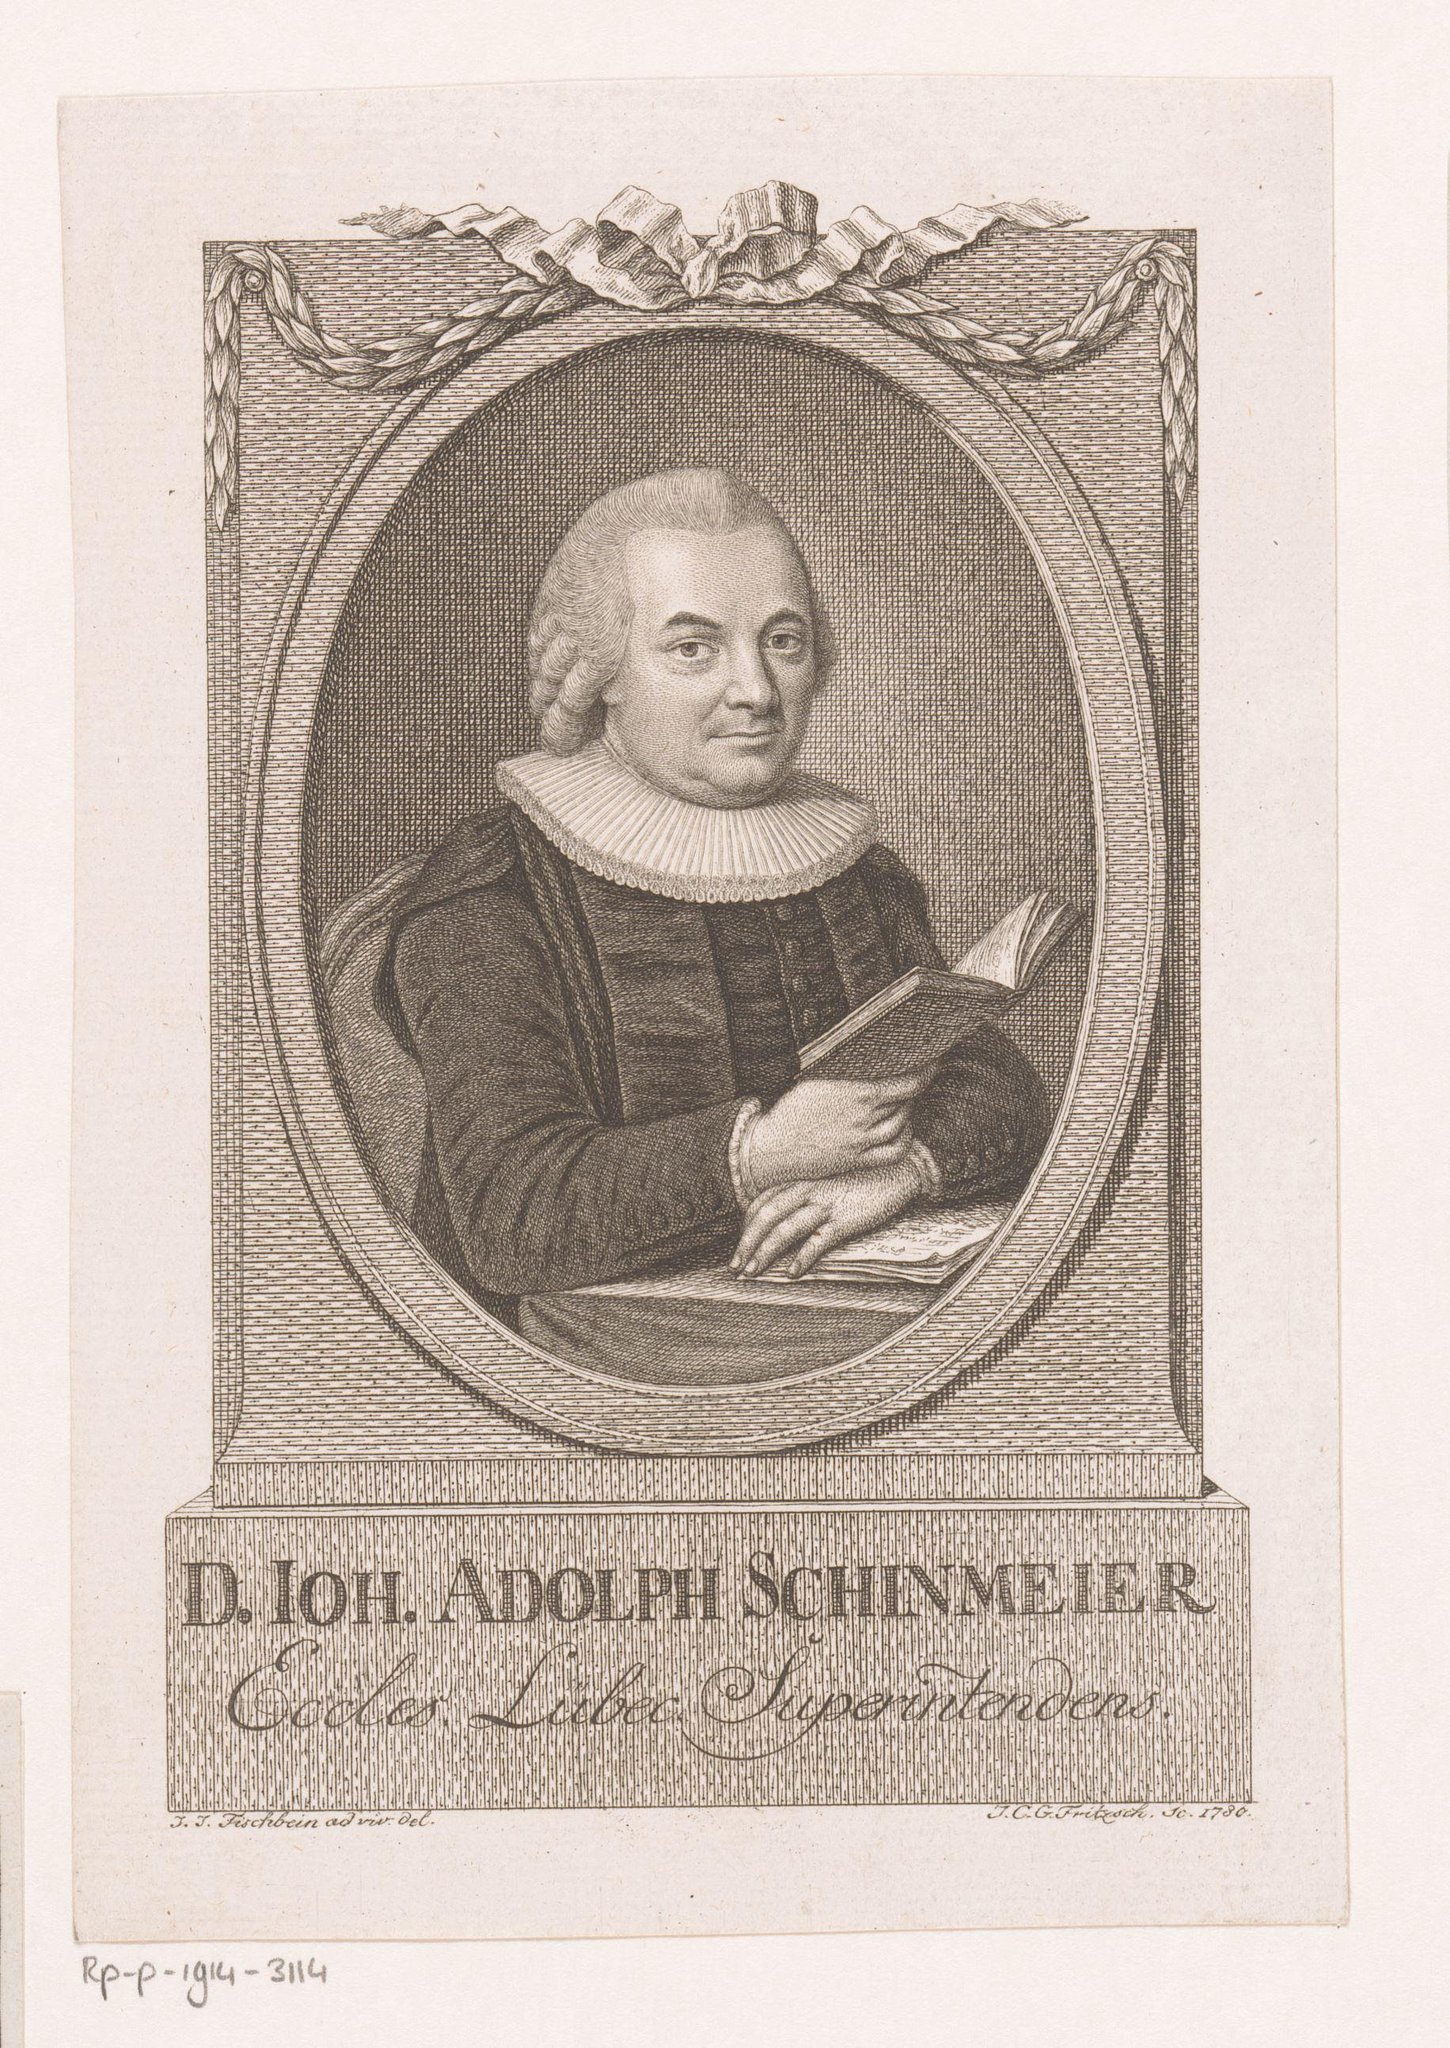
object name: print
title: Portret van Johann Adolf Schinmeyer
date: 1780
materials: paper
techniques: engraving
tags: ornament ~ medallion, historical persons, ornament ~ festoon, garland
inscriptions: collector's mark: Lugt 2228